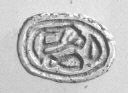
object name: stamp seal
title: Scarab seal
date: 1700-1560 BCE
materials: stone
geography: levant